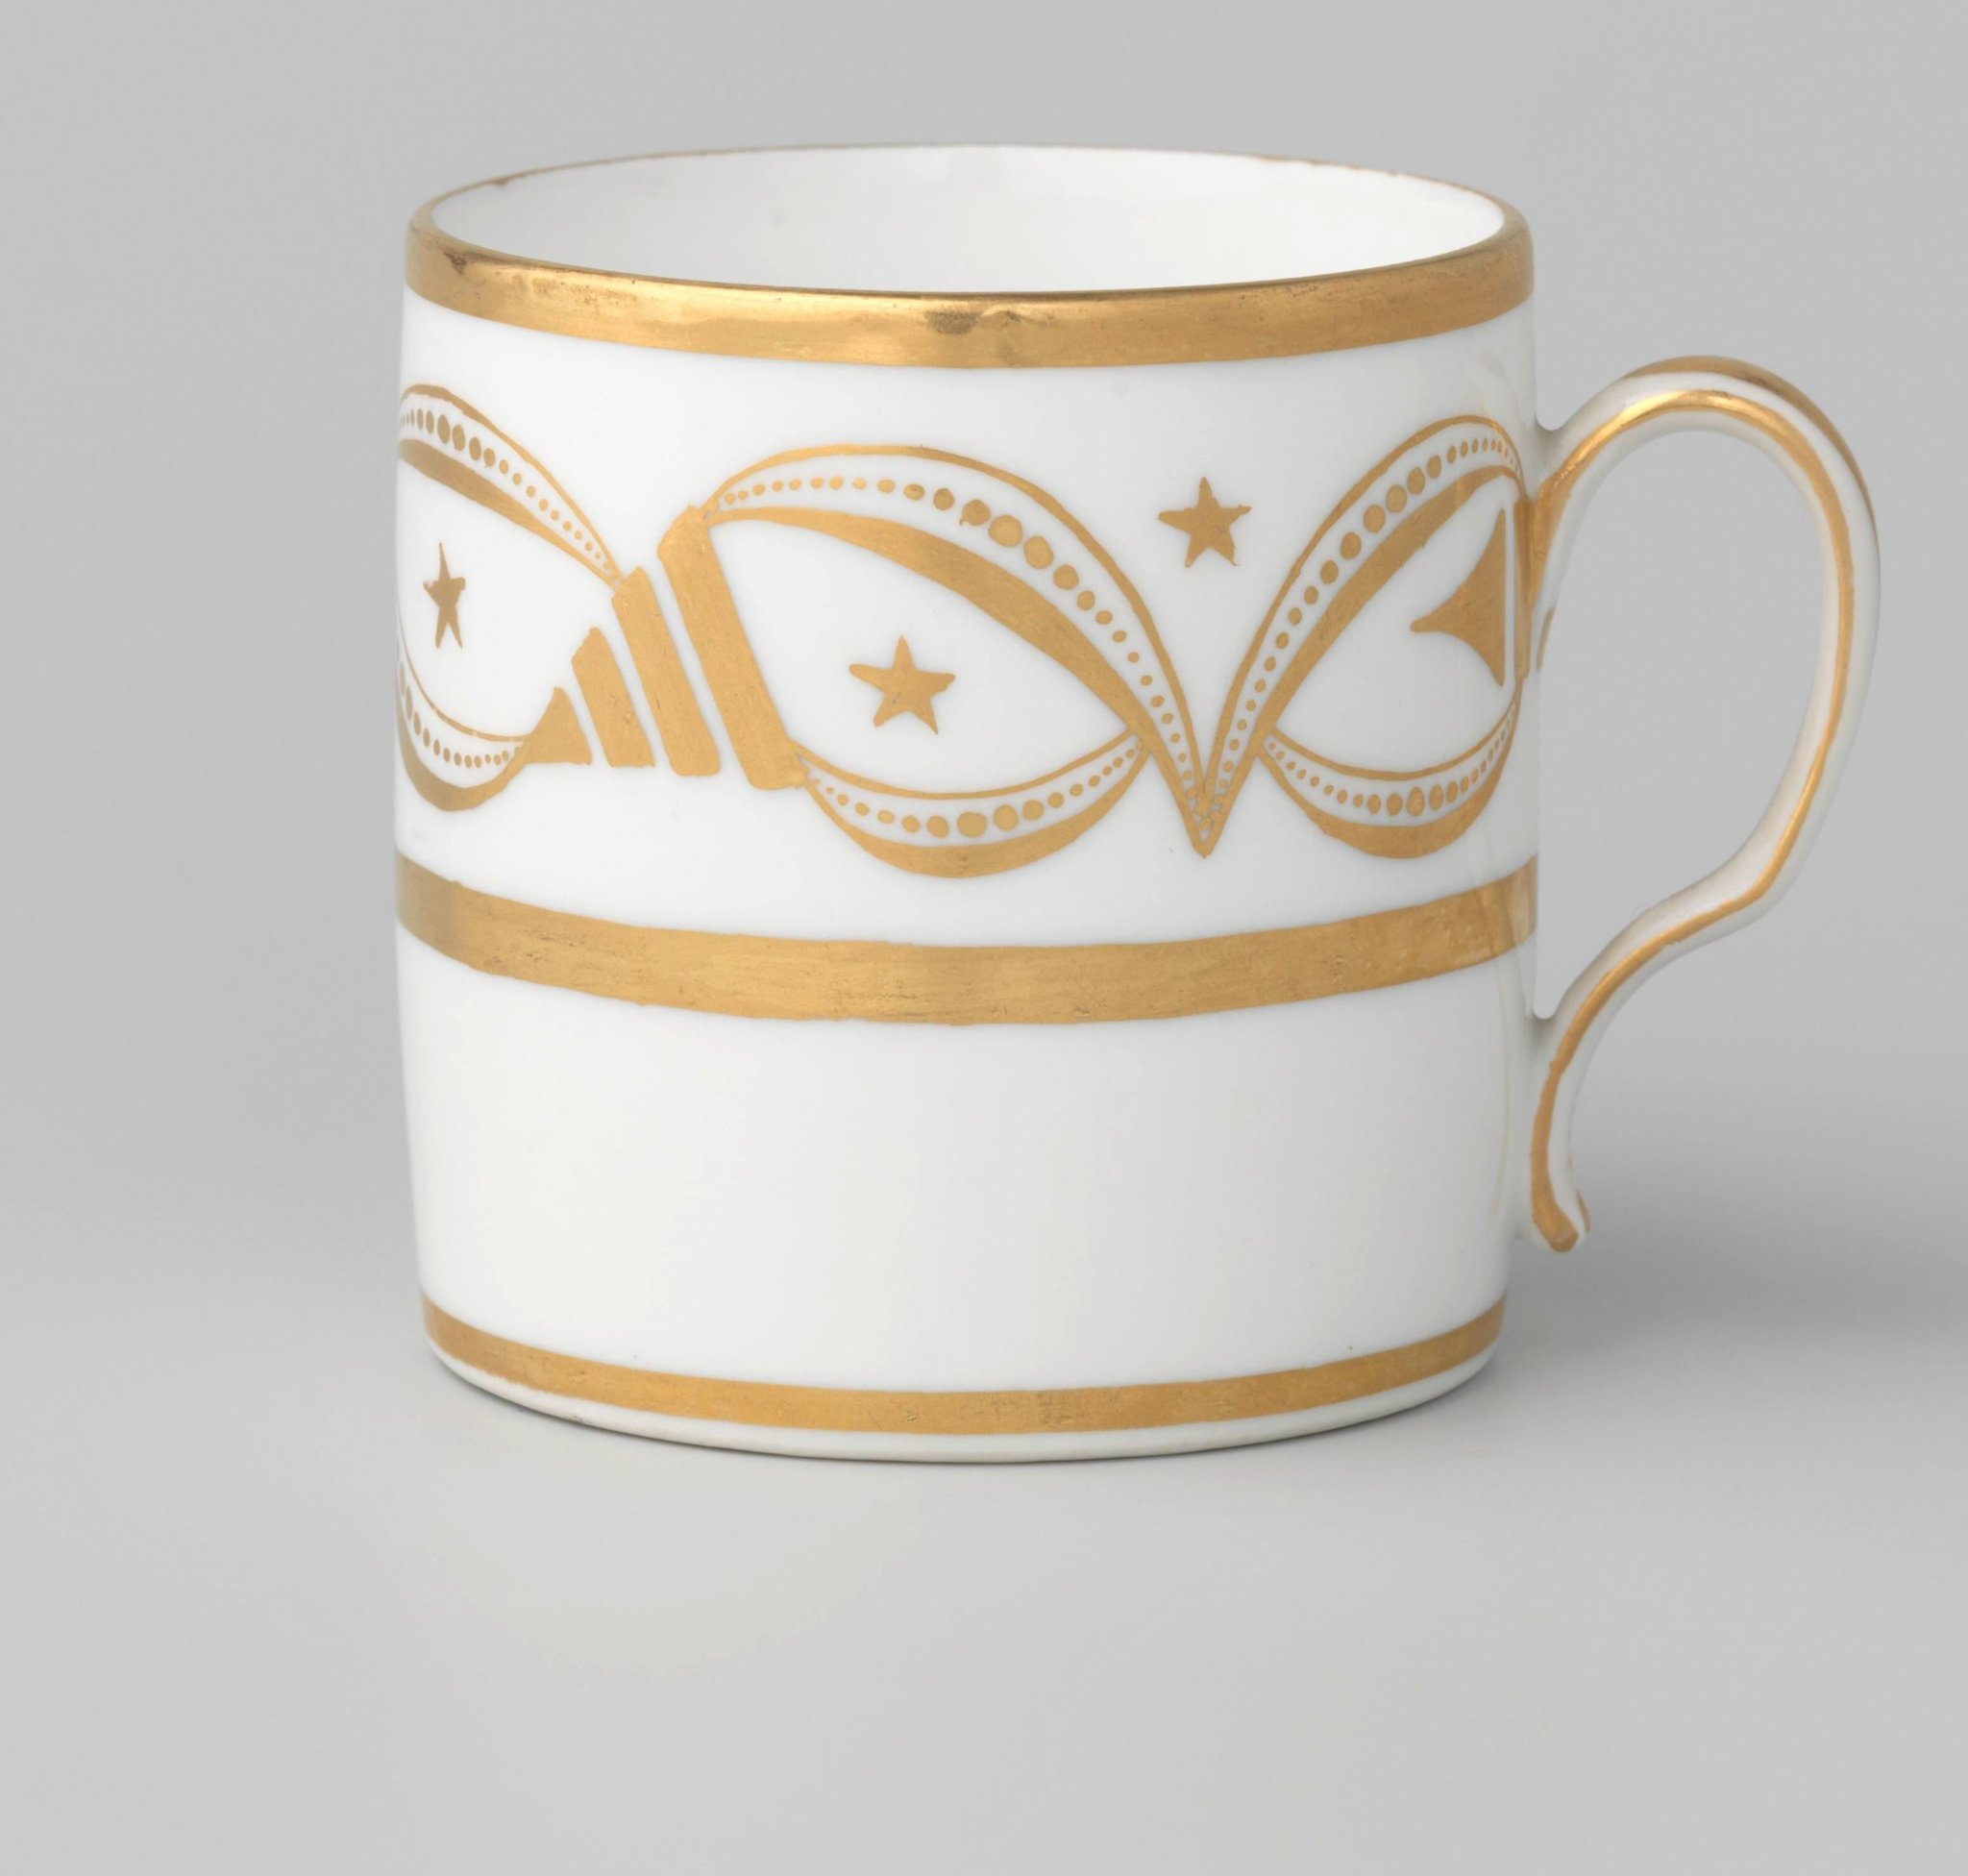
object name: service set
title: Cup with an ornamental border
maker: Anonymous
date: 1800-1824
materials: glaze, gold, paint, porcelain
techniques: firing, forming, gilding, turning, vitrification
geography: france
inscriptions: mark: ‘f’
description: Kop van porselein, recht model met oor, versierd met gouden banden waartussen een slingermotief dat wordt gevormd door halvemaanvormige schijven waarin punten. De schijven worden verbonden door driehoeken. Op de tussenliggende velden gouden sterren. Behoort tot een serie van twaalf kop-en-schotels (F-1-24), onderdeel van een koffie- en theeservies. Opmerking: van één kop is het oor afgebroken.